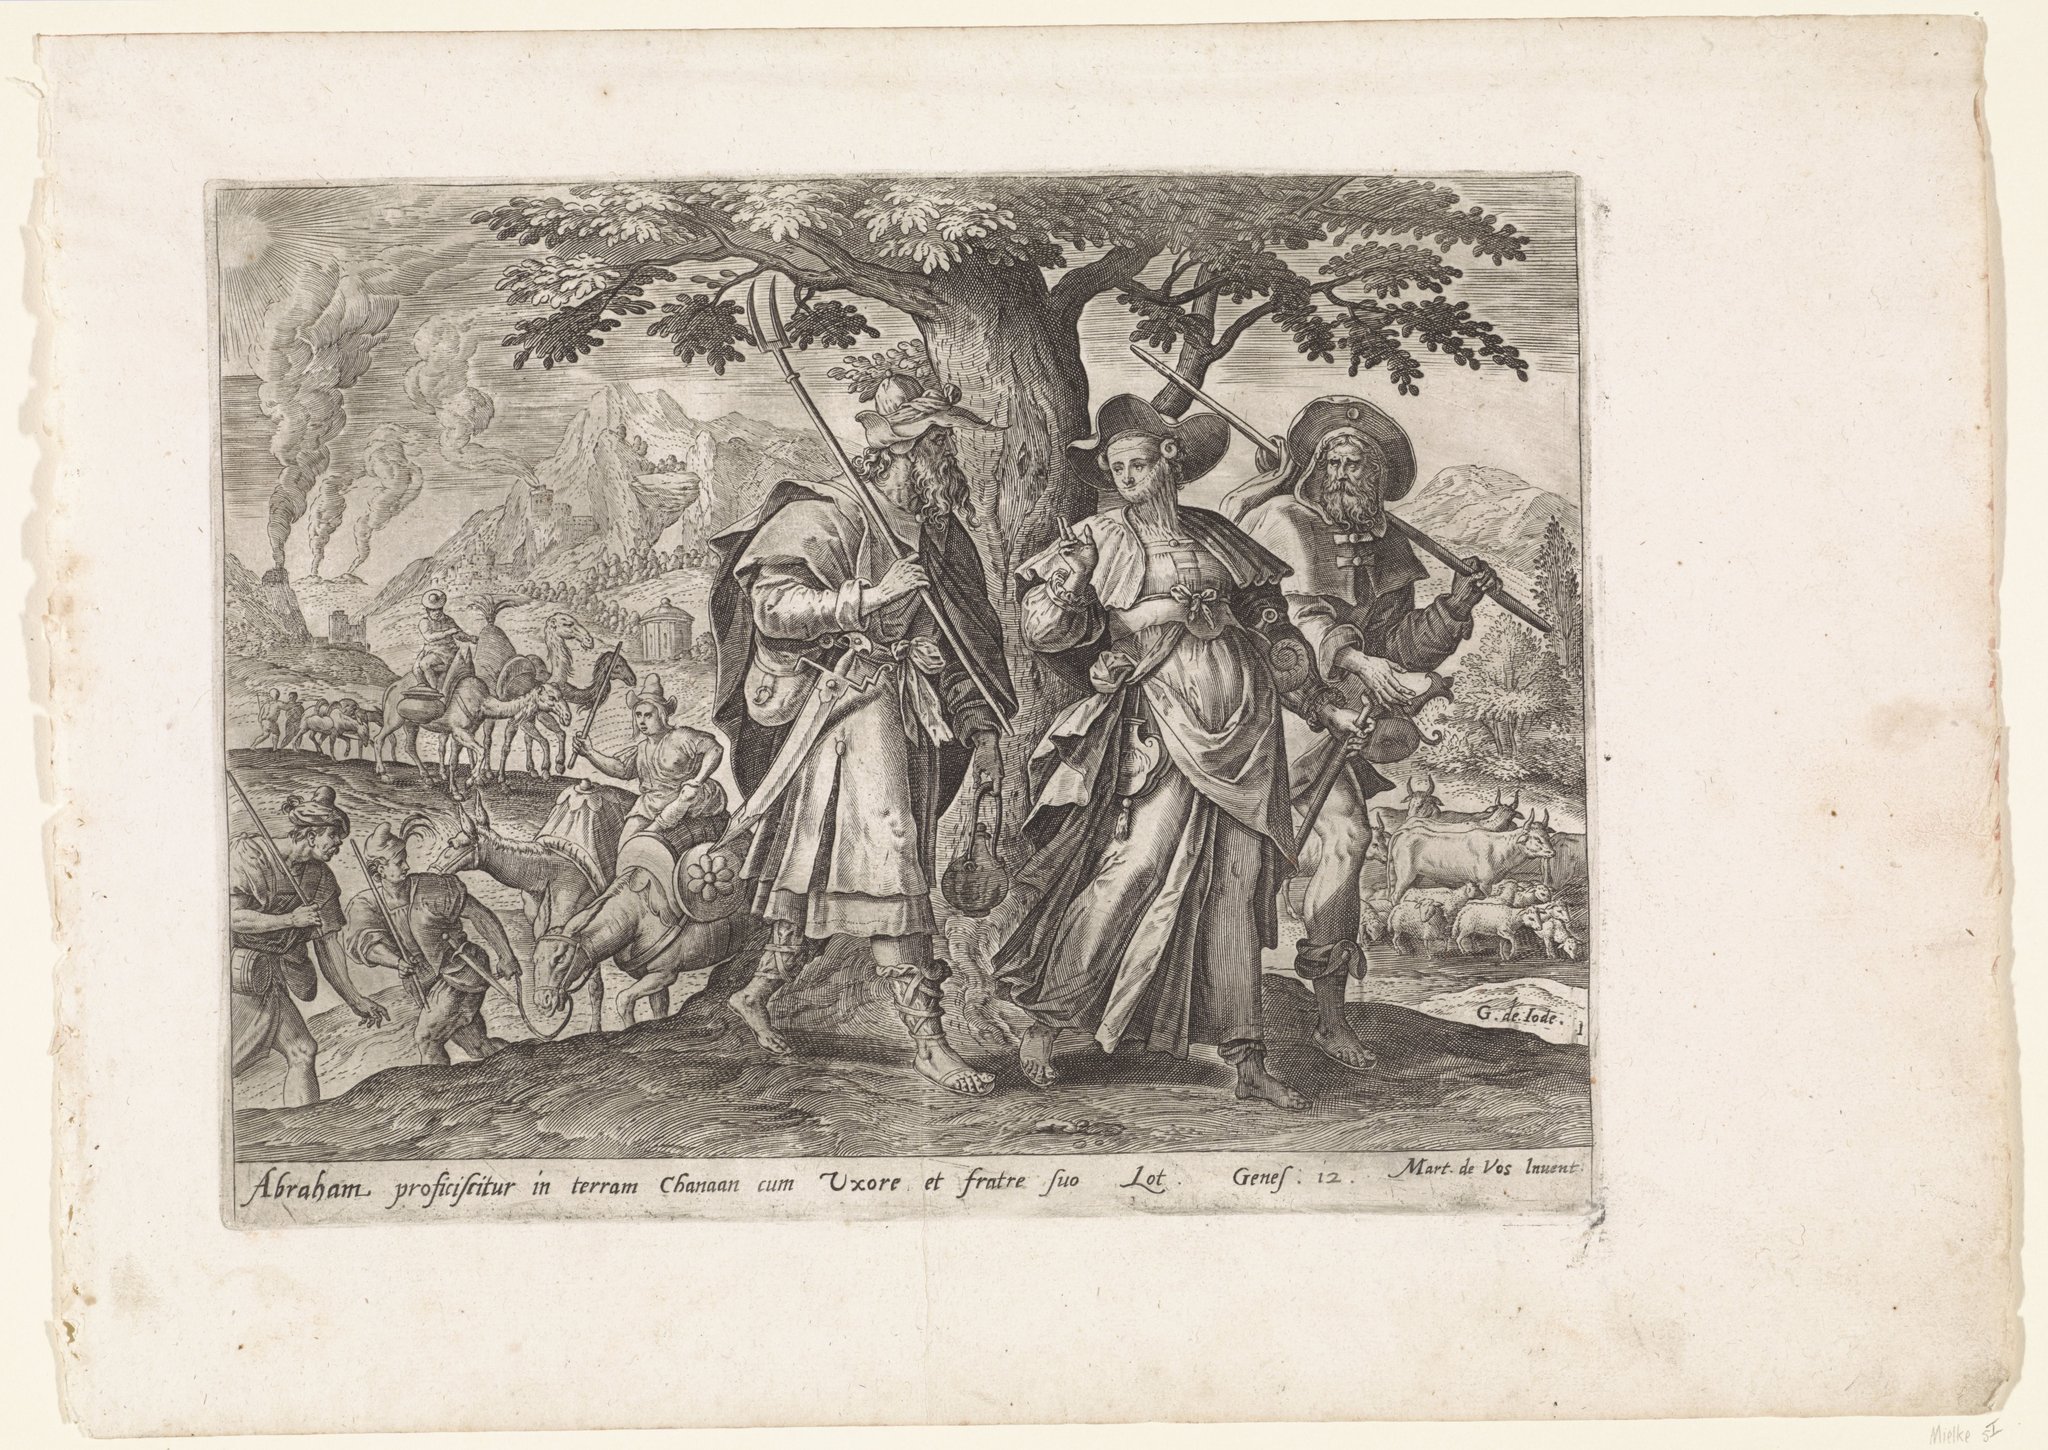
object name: print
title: Thesaurus sacrarum historiarum veteris testamenti (...)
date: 1585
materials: paper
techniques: engraving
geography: antwerp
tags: abraham starts out for the land of canaan with sarah, lot and his belongings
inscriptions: collector's mark: Lugt 2228, collector's mark: Lugt 2760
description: Abraham vertrekt met zijn familie, tot slaaf gemaakte mannen en vrouwen en vee naar Kanaän. Op de voorgrond in het landschap lopen Abraham, zijn vrouw Sara en zijn neef Lot. Onder de voorstelling een verwijzing in het Latijn naar de Bijbeltekst in Gen. 12.